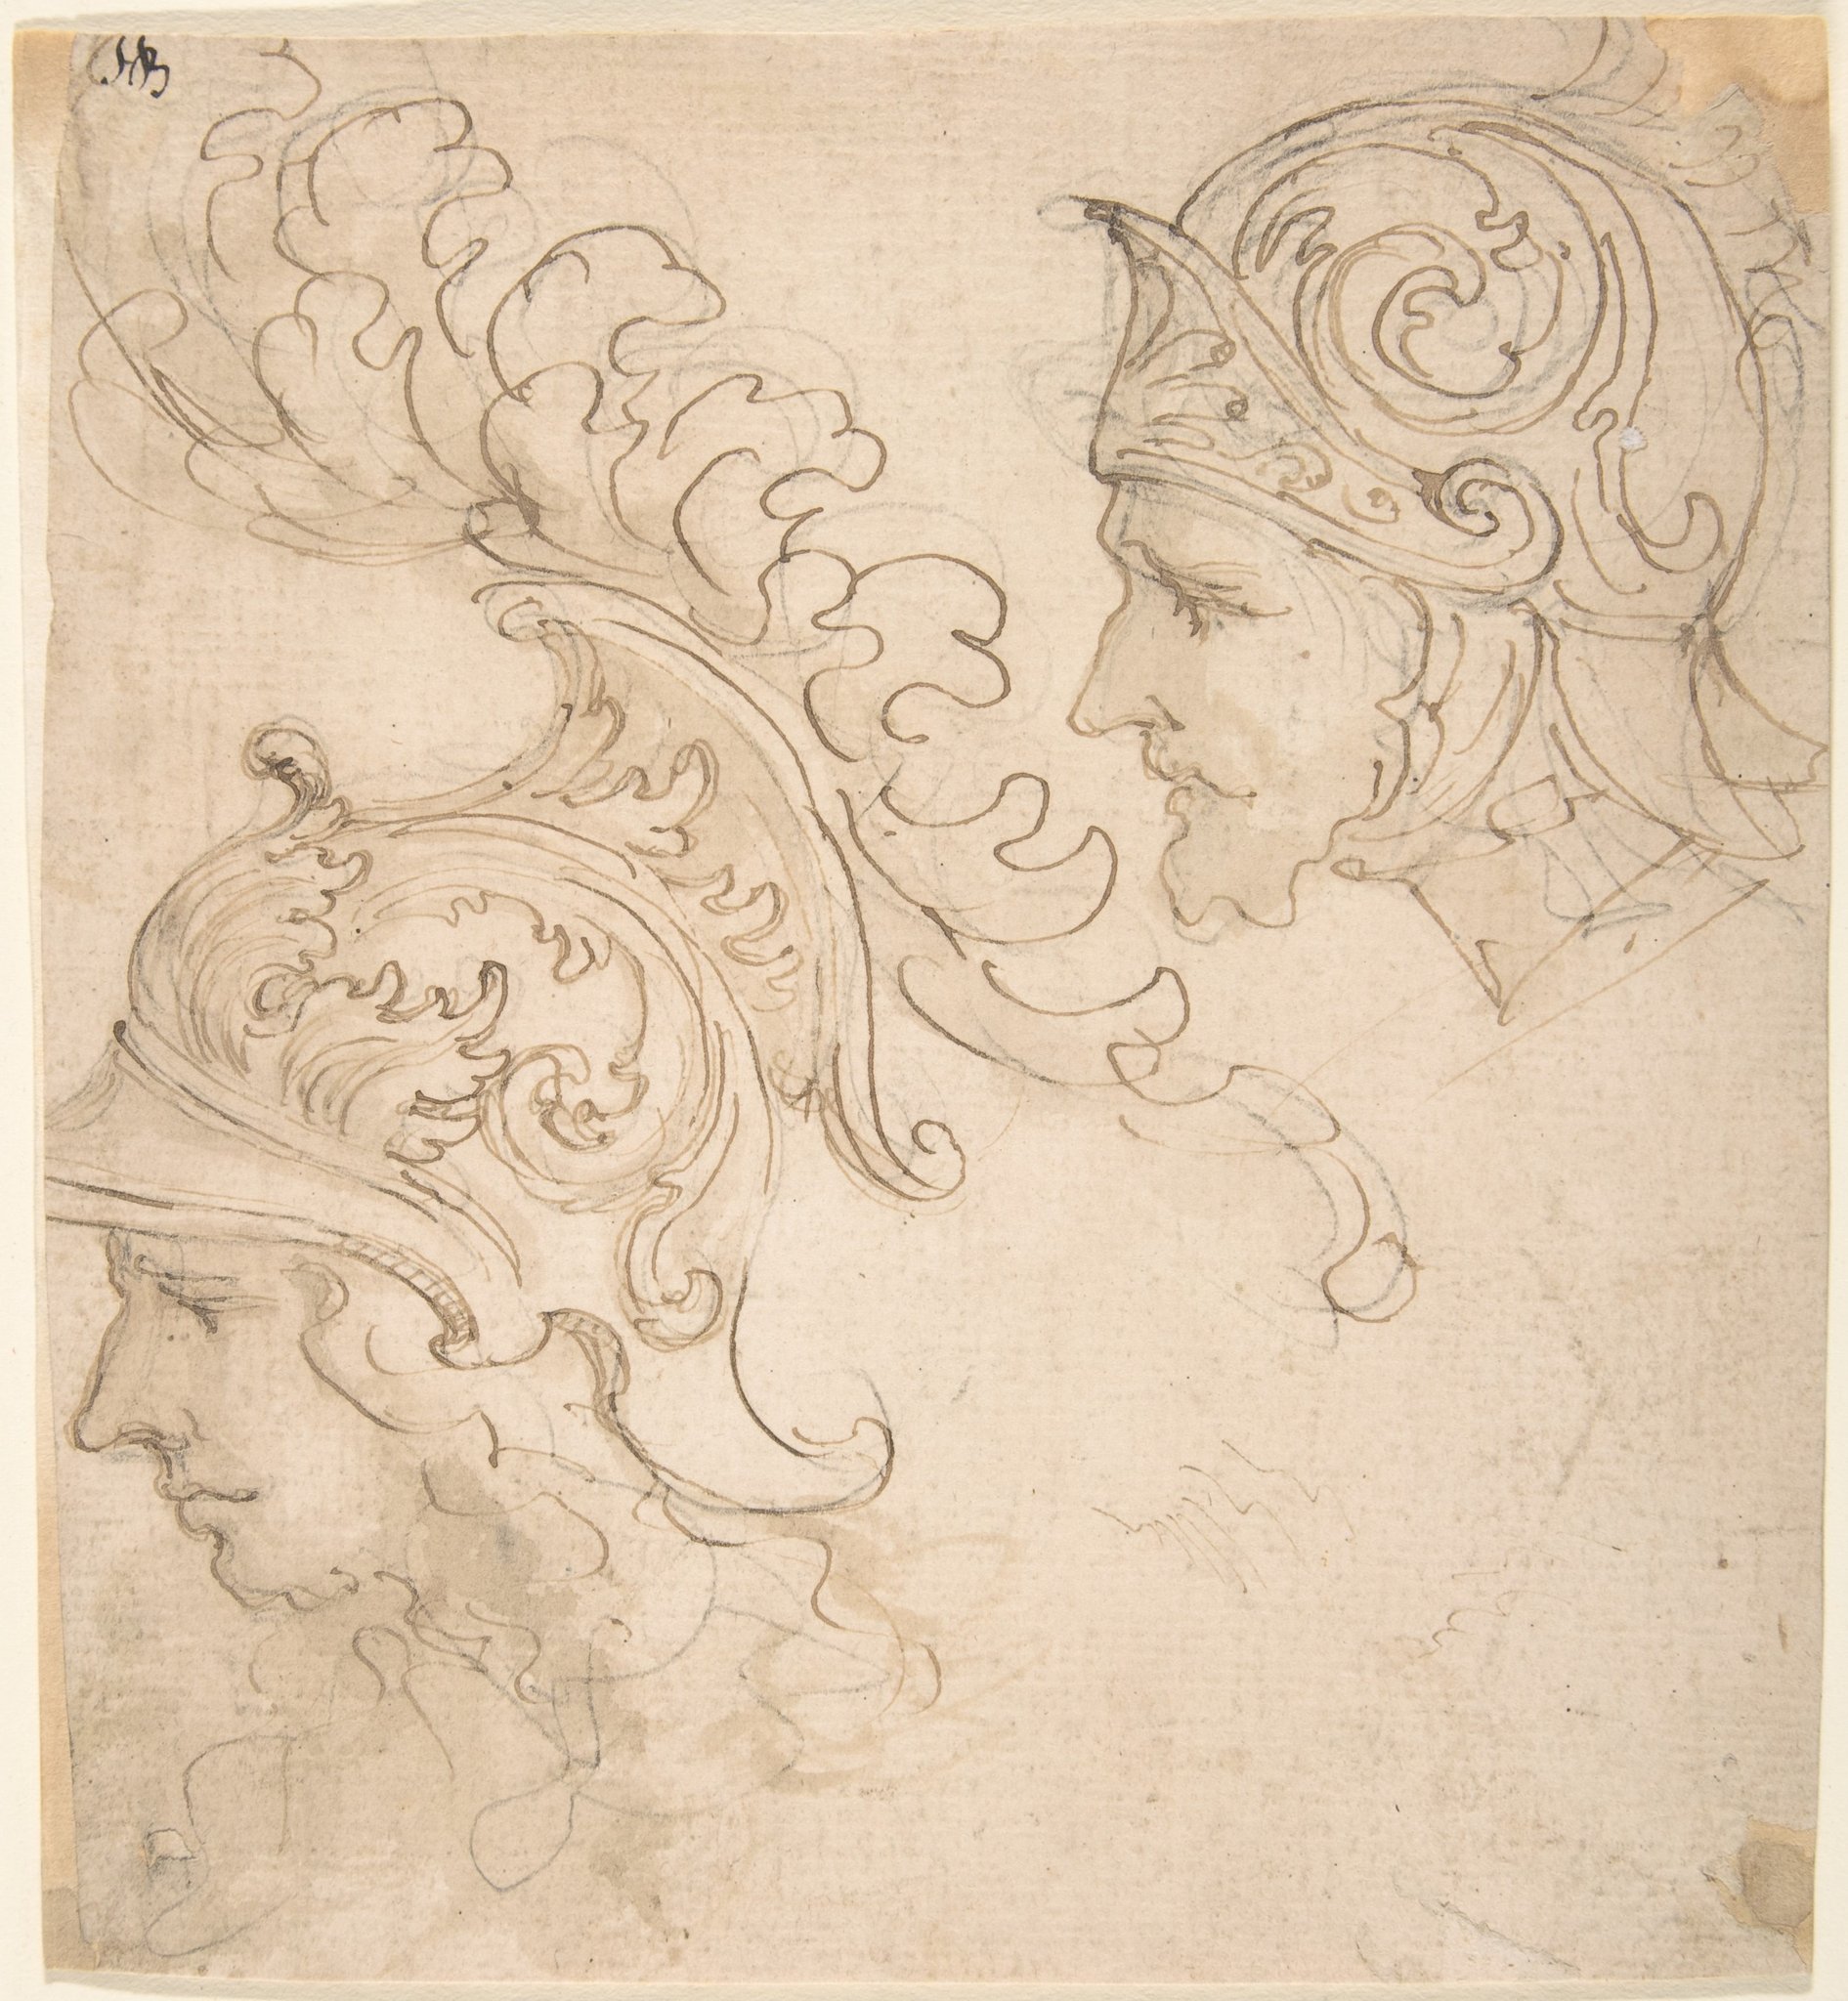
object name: drawing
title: Two Studies for Helmet Designs Presented En Profil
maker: giovanni battista foggini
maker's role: artist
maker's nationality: italian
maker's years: 1652-1725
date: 1672-1725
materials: chalk, ink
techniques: brush, pen, wash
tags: helmets,heads